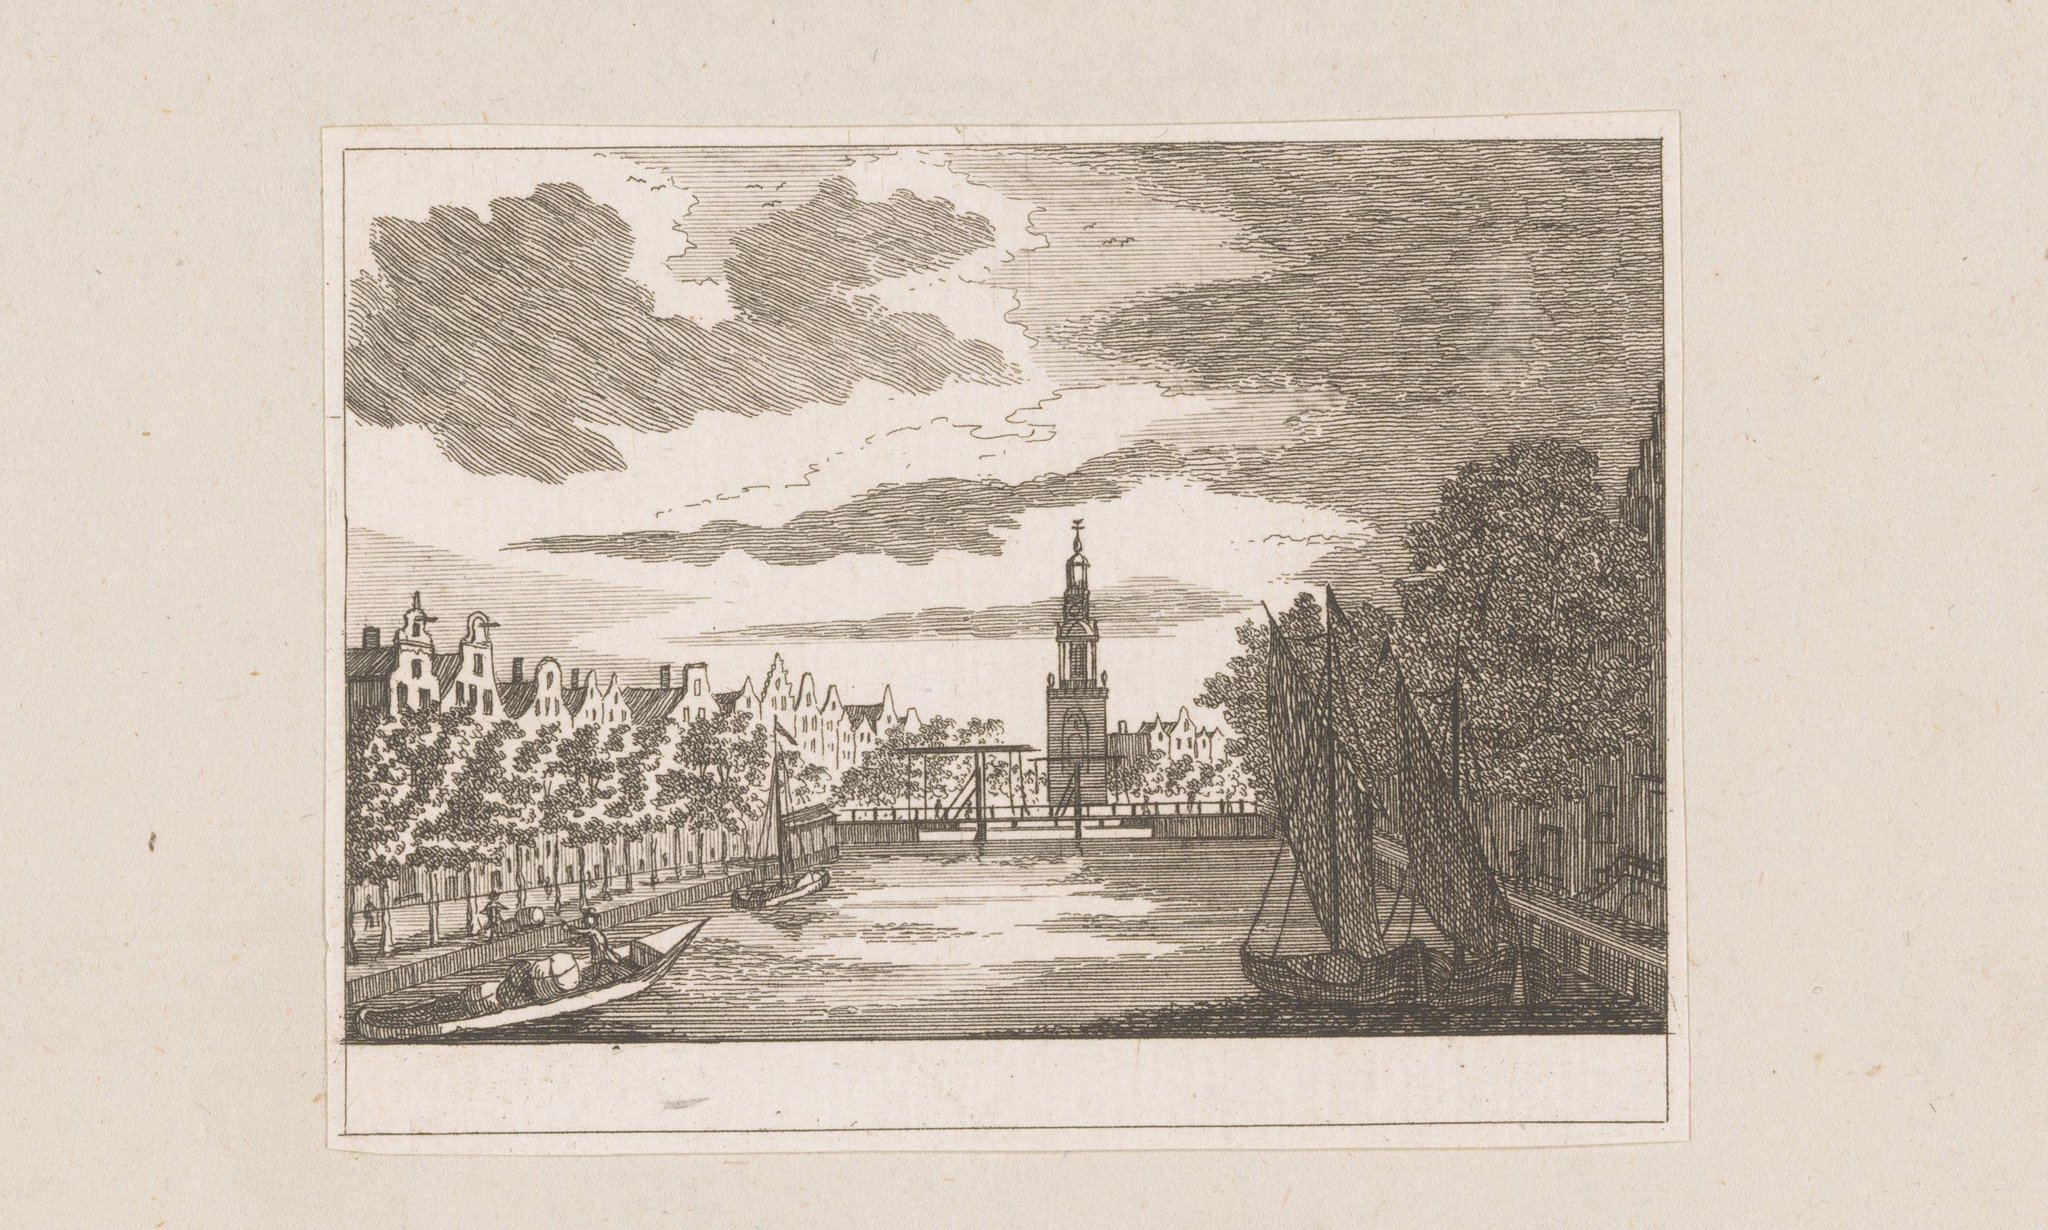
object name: print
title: Gezicht op de Jan Roodenpoortstoren in Amsterdam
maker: Anonymous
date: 1700-1799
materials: paper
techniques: etching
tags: sailing-ship, sailing-boat, tower, clock tower ~ monumental adornment, towers ~ fortified city, bridge in city across river, canal, etc.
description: Gezien de lege ruimte onder de prent waarschijnlijk een proefdruk of vroege staat voor de letter.